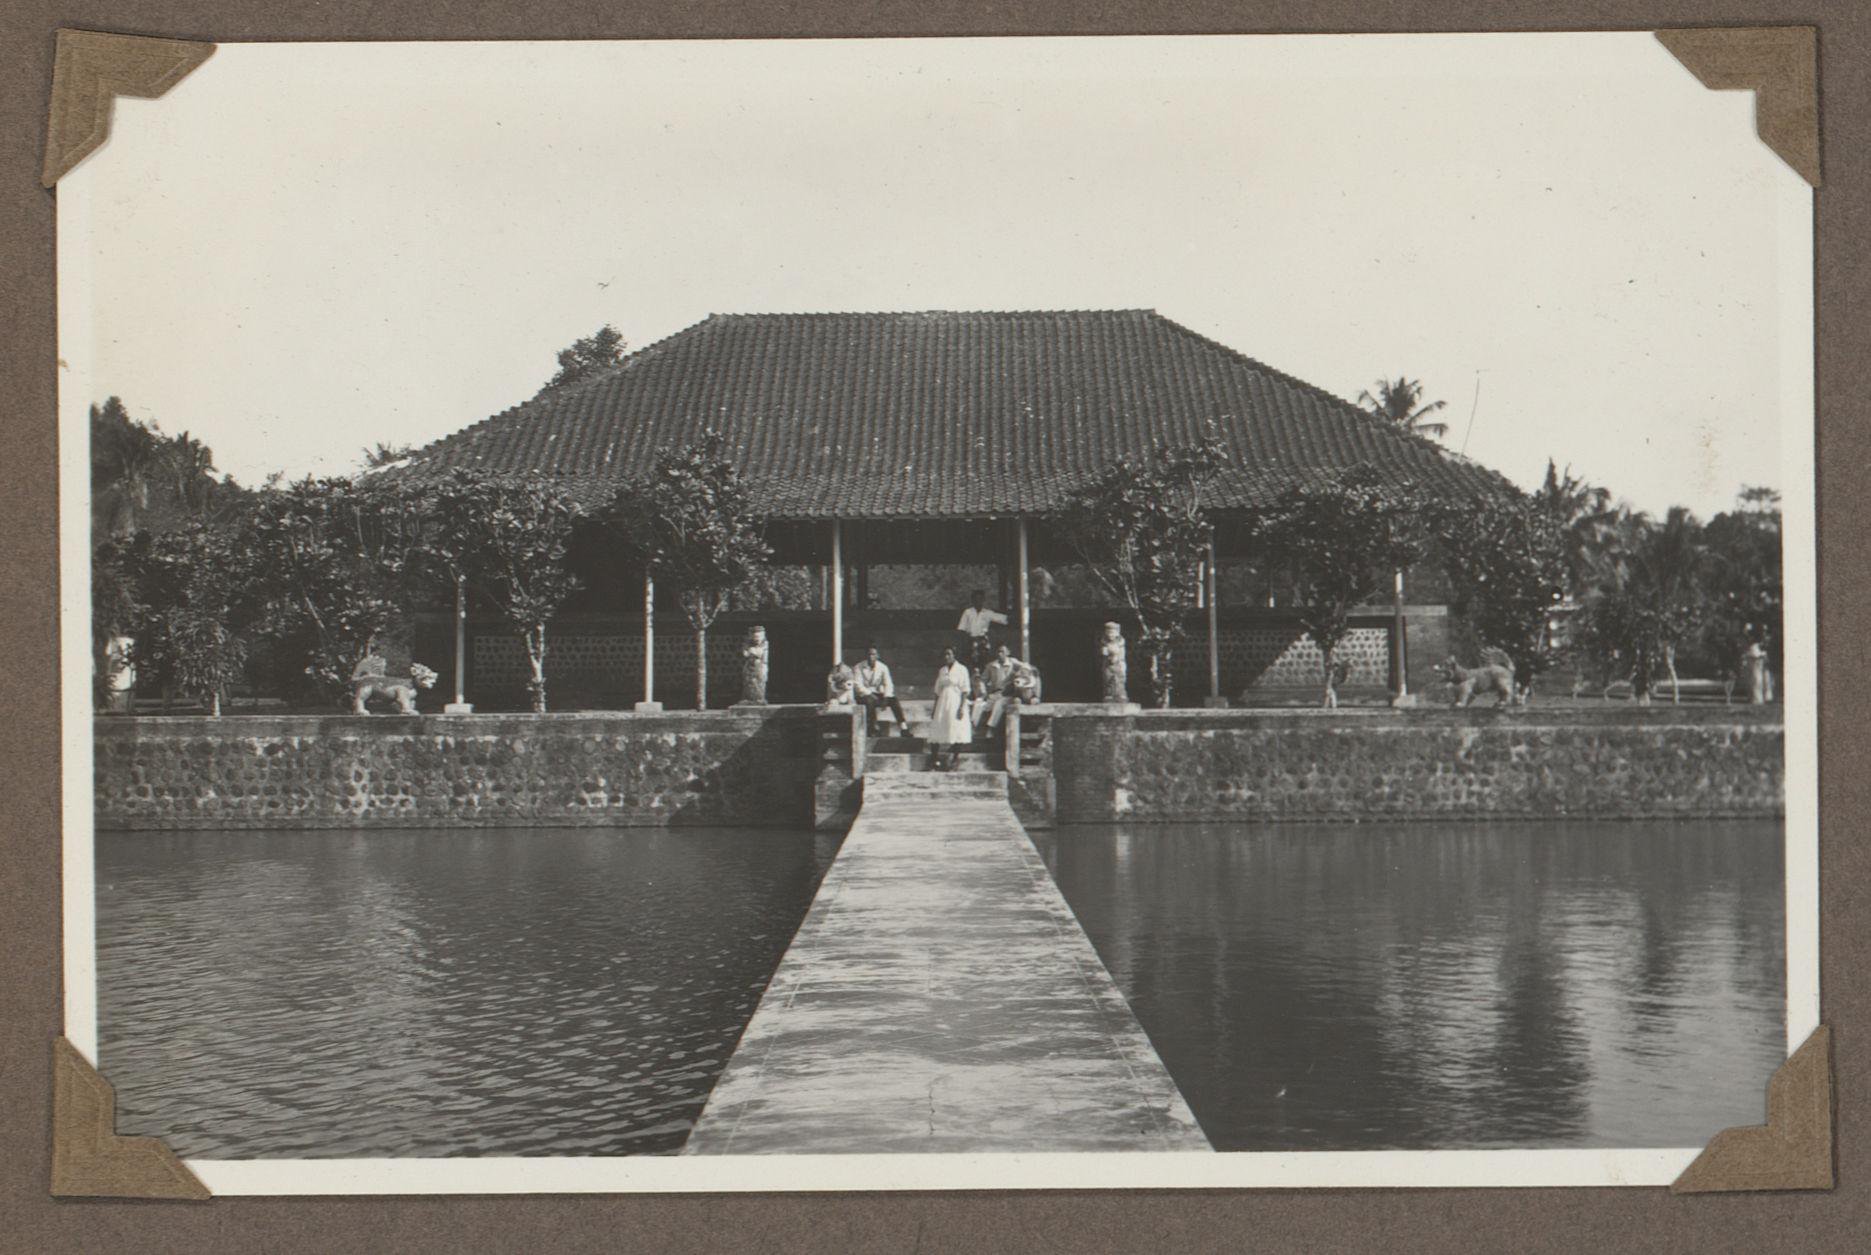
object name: photograph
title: Mayura waterpaleis te Cakranegara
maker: Anonymous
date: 1930-1935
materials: paper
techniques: gelatin silver print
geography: cakranegara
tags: palace